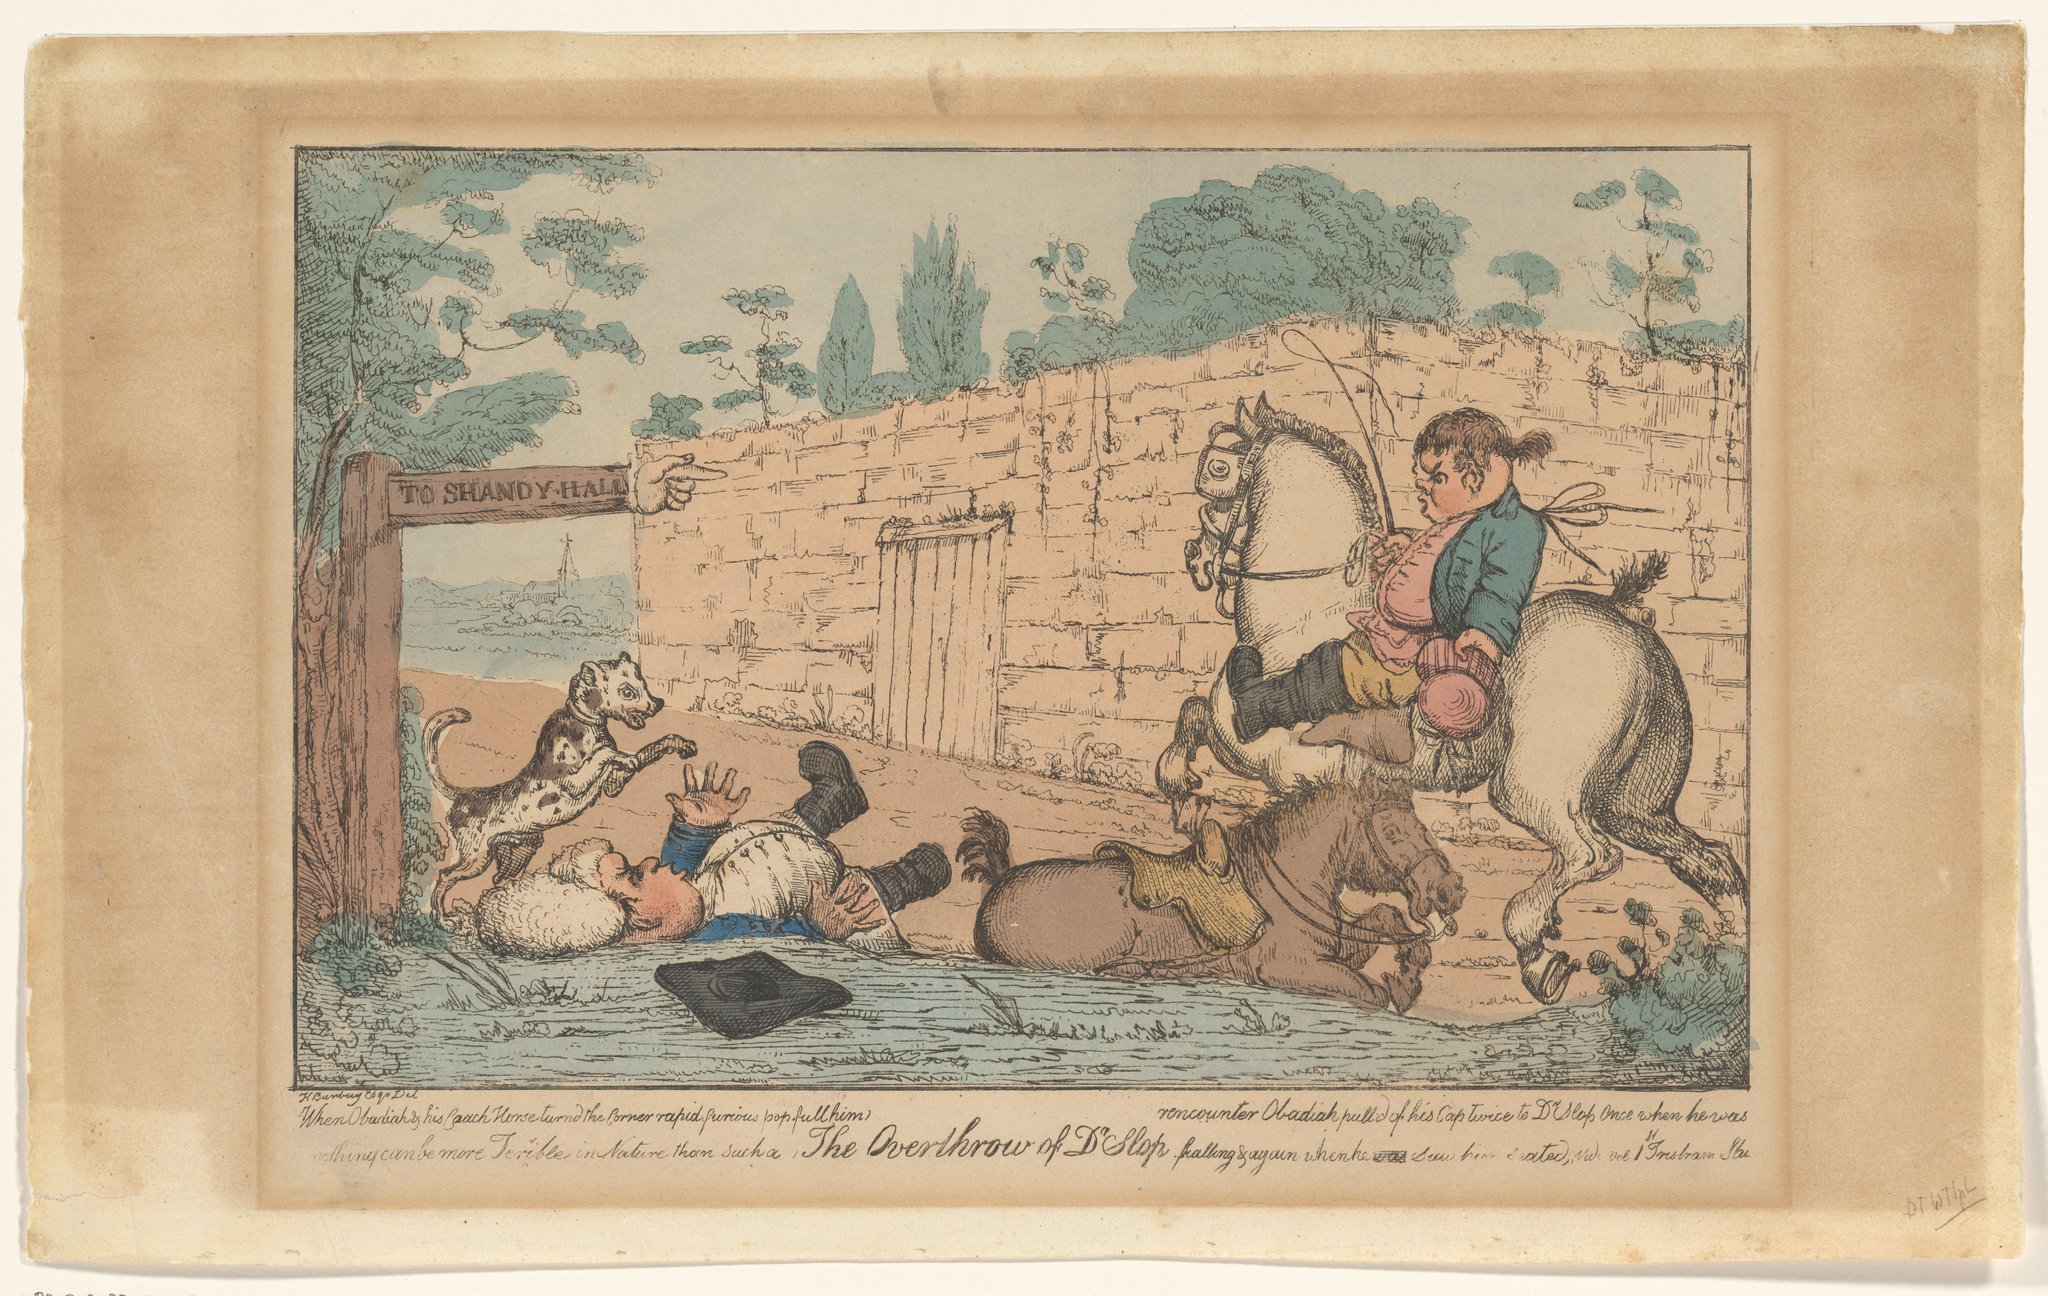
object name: print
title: The Overthrow of Dr. Slop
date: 1759-1767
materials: paper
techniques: etching, hand coloring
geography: europe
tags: riding a horse, ass, or mule; rider, horseman, caricatures (human types), (scenes from) specific works of literature (with author, title), accident with horse (or kindred animal)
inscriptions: collector's mark: Lugt 2228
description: Obadiah brengt zijn zij galopperende paard tot halt te brengen. Op de grond liggen de gevallen dr. Slop en zijn pony. Een gevlekte hond springt over de dokter heen die onder een wegwijzer "To Shandy Hall" ligt. Een illustratie voor Laurence Sterne’s The Life and Opinions of Tristram Shandy, Gentleman (York 1759-1767).